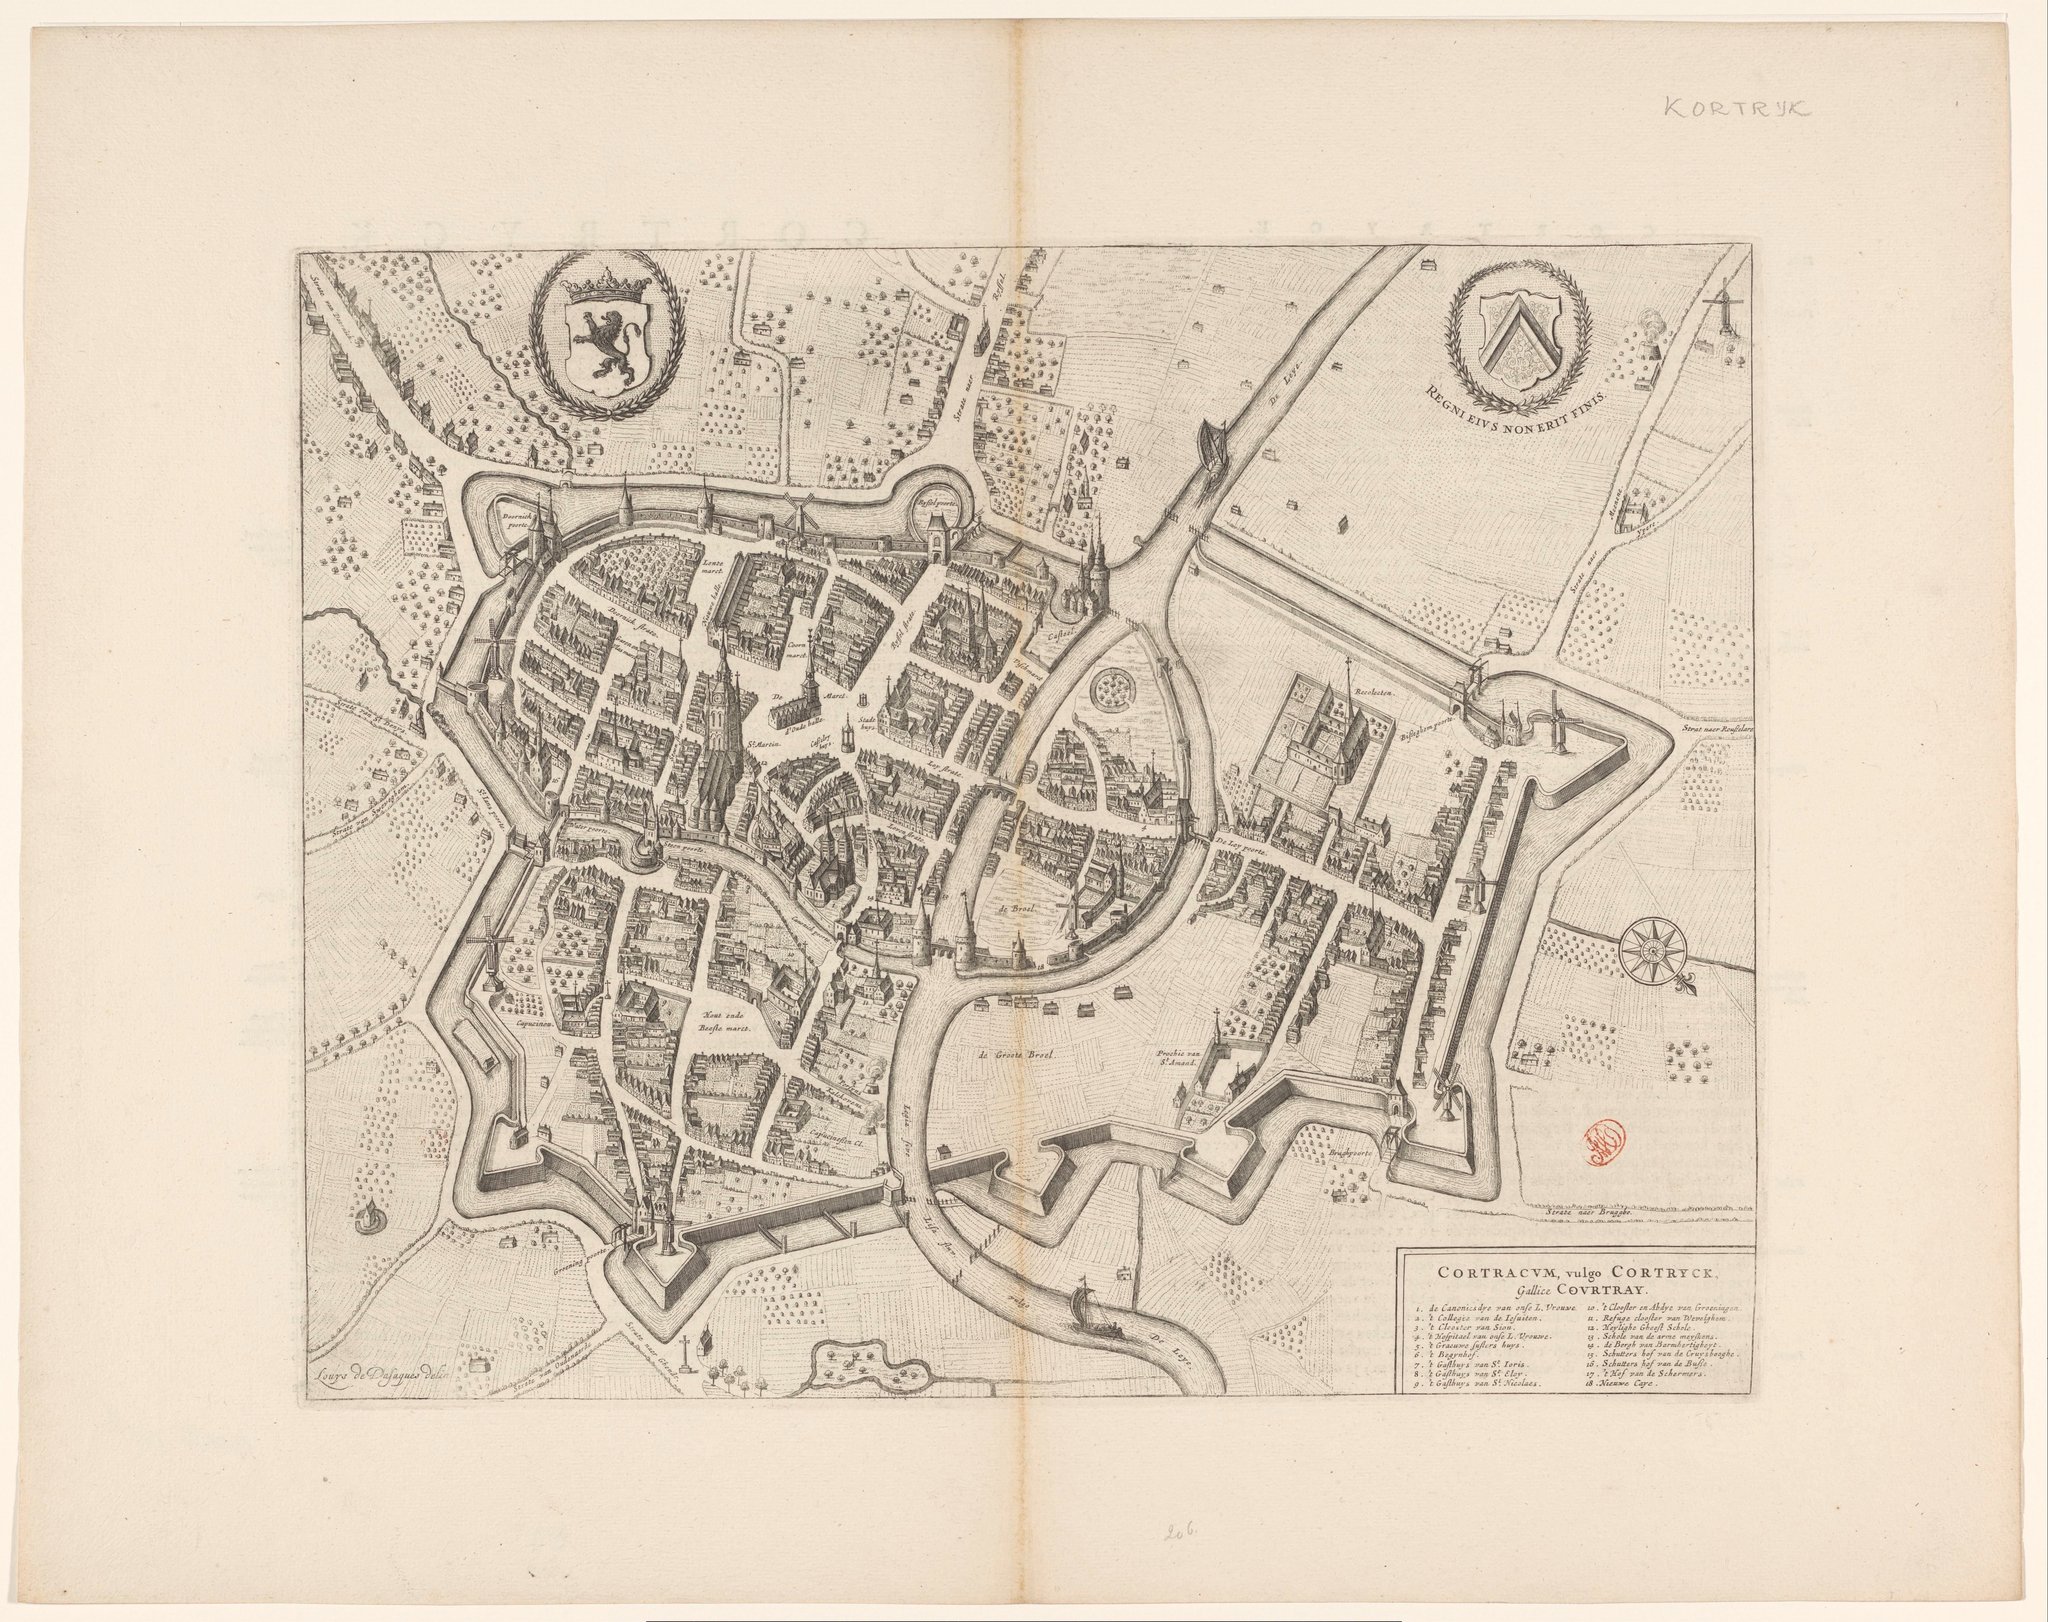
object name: print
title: Plattegrond van Kortrijk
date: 1652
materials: paper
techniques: engraving, etching, letterpress printing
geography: amsterdam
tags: coat of arms (as symbol of the state, etc.) (+ city; municipal), fortified city, maps of cities, coat of arms (as symbol of the state, etc.) (+ province; provincial)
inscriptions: collector's mark: Lugt 195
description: Plattegrond van Kortrijk in vogelvluchtperspectief. Rechtsonder een kader met titel en legenda 1-18. Linksboven het wapen van Vlaanderen. Rechtsboven het wapen van Kortrijk met daaronder een credo. Met Nederlandse tekst op verso.